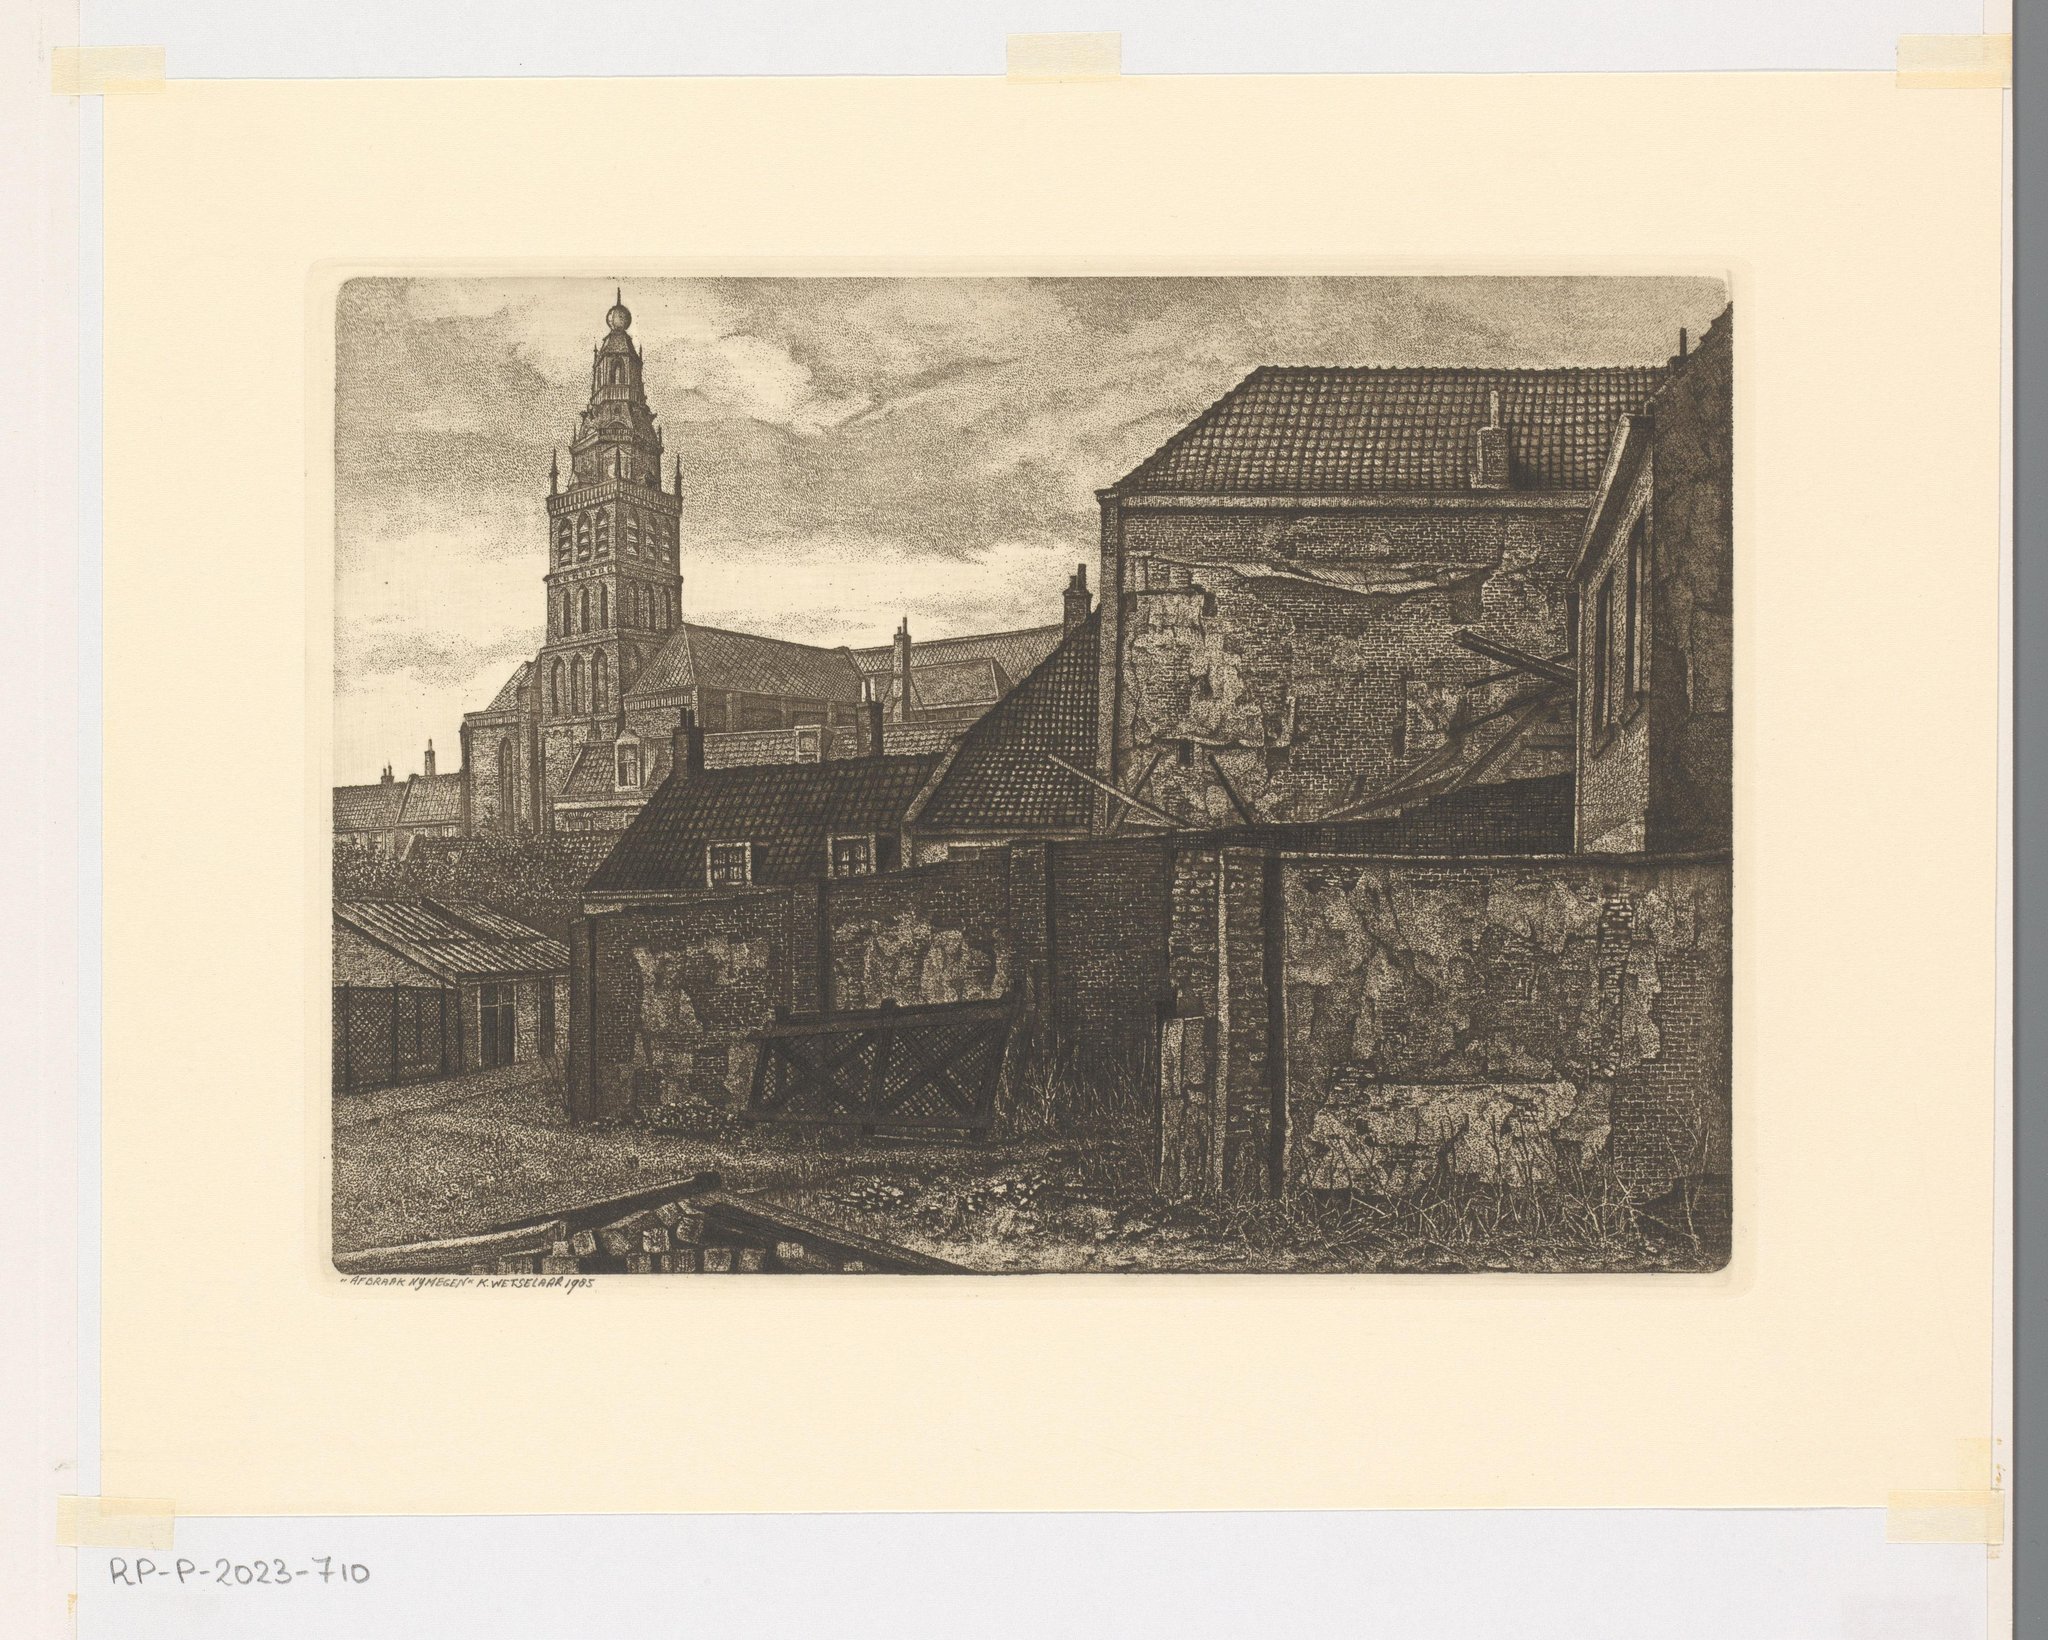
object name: print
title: Afbraak Nijmegen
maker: karel wetselaar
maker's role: print maker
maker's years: 1935-2017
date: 1985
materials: paper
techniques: etching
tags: church (exterior), demolition of building, nijmegen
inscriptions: signature and date: ‘K. Wetselaar 1985’